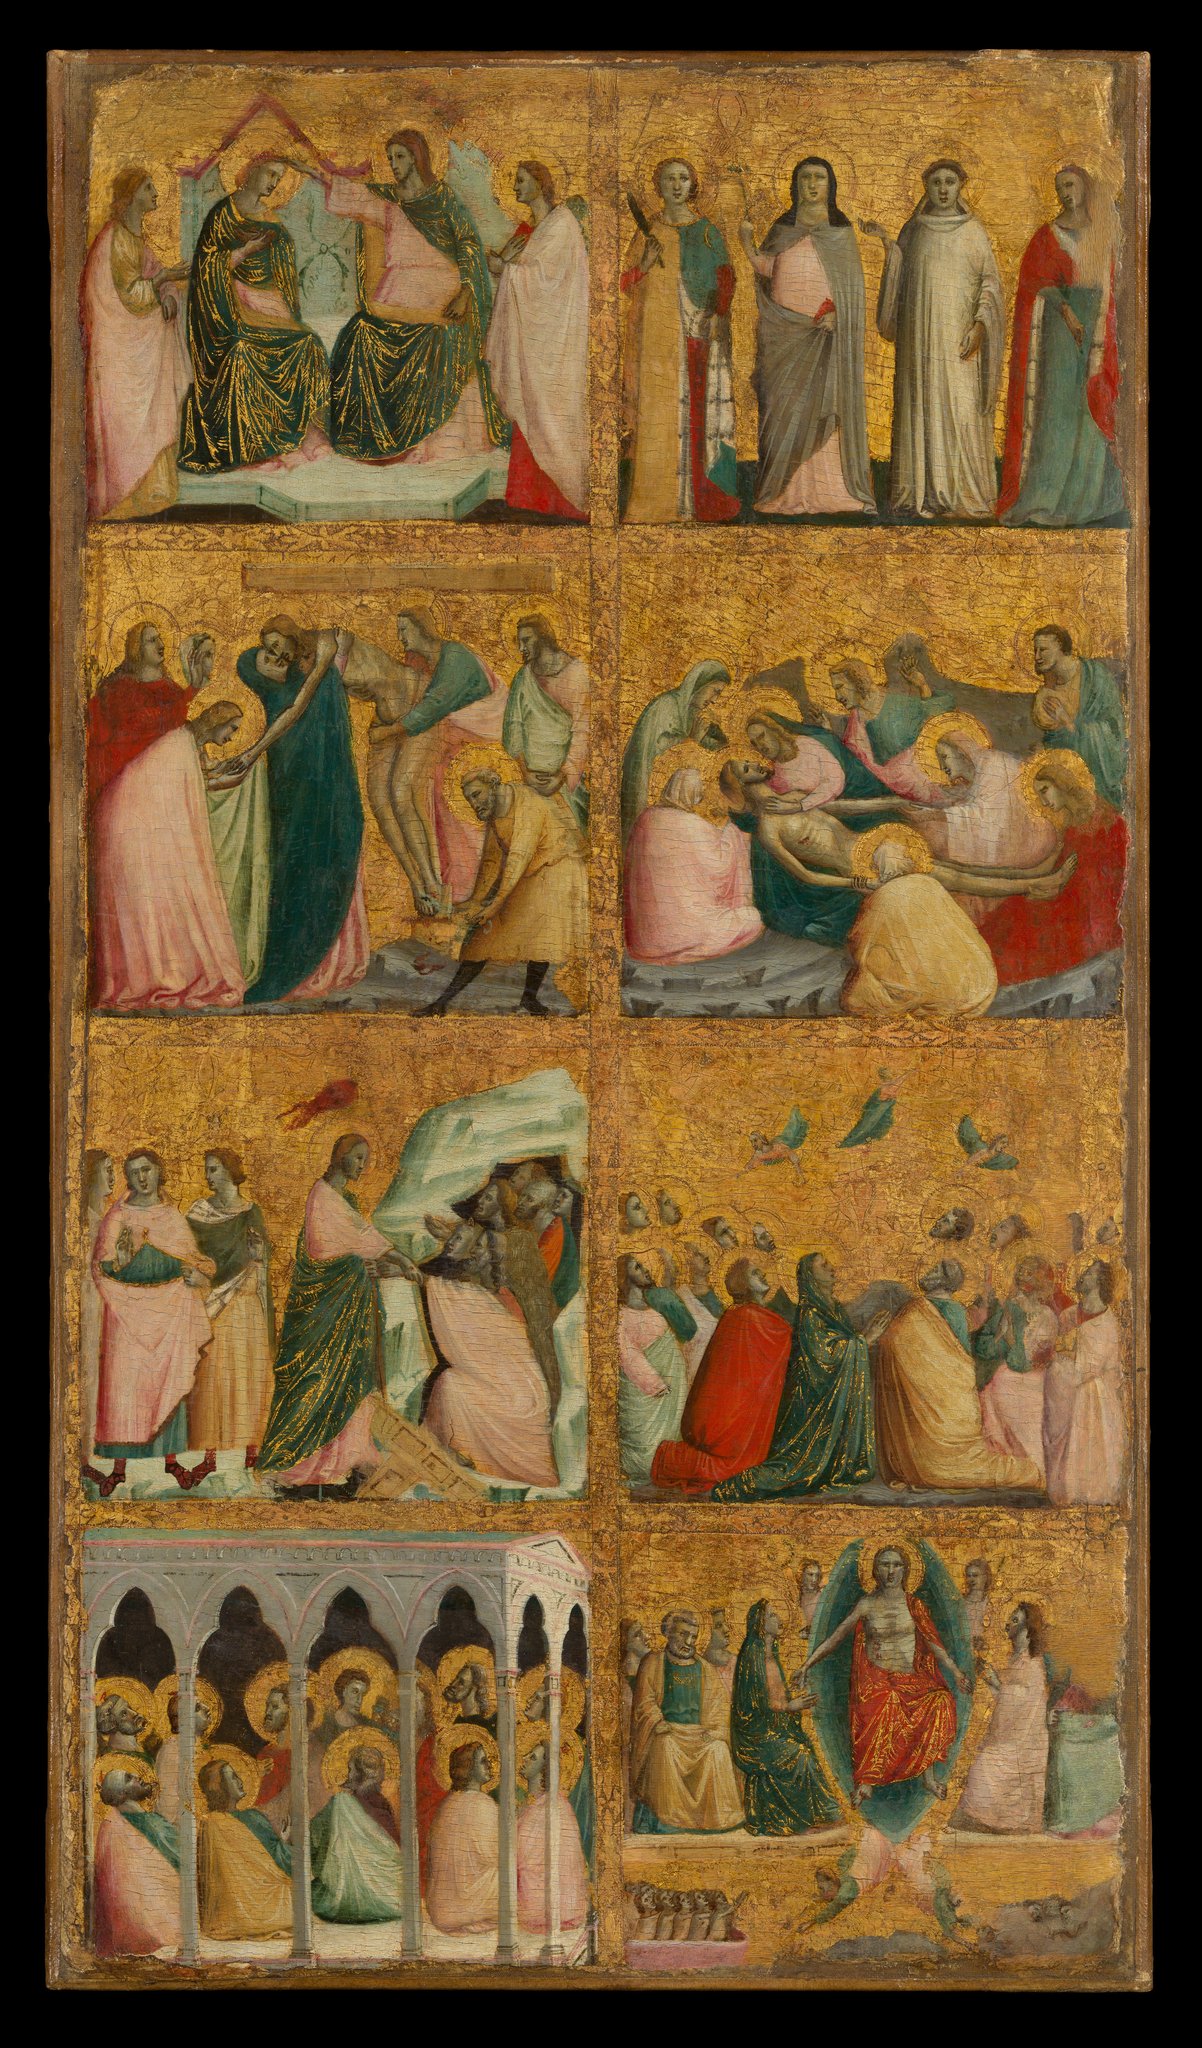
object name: painting, right wing of a diptych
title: Scenes from the Life of Christ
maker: giovanni baronzio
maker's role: artist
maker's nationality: italian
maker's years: 1325-1349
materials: canvas, gold leaf, paint, wood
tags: men,women,christ,virgin mary,last judgement,saints,coronation of the virgin